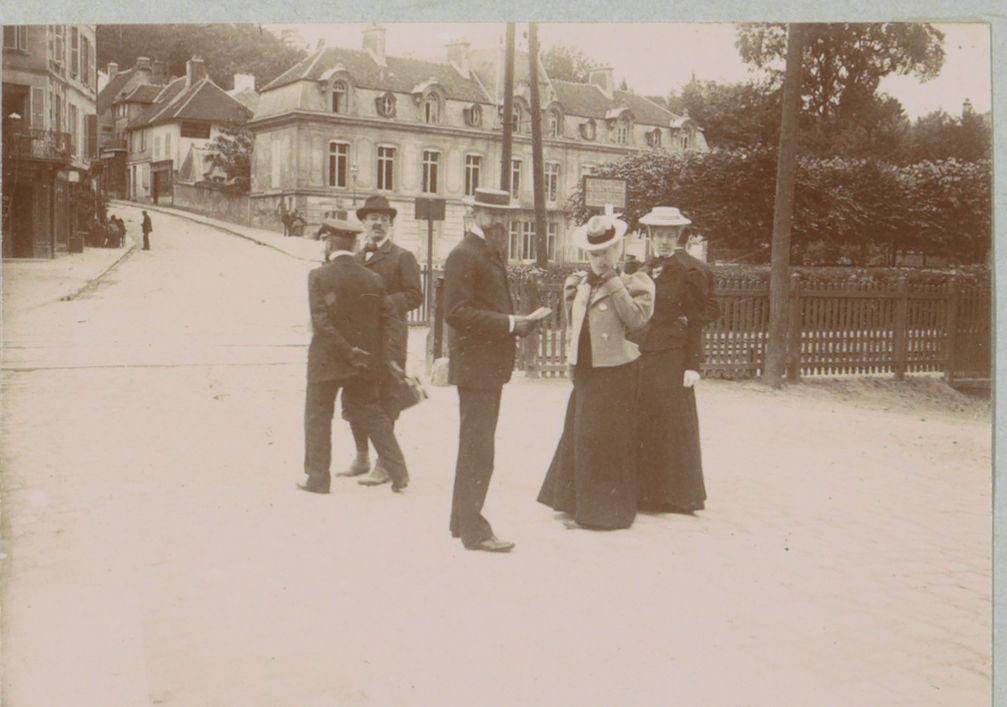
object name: photograph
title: Gezelschap op straat in L'Isle-Adam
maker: delizy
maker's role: manufacturer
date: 1898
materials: paper, photographic support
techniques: daylight paper print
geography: l'isle-adam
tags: village street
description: Onderdeel van Fotoalbum van een Franse amateurfotograaf met opnames van uitstapjes in Frankrijk, Spanje, België, Luxemburg en Nederland, de eerste automobielen en autoraces.